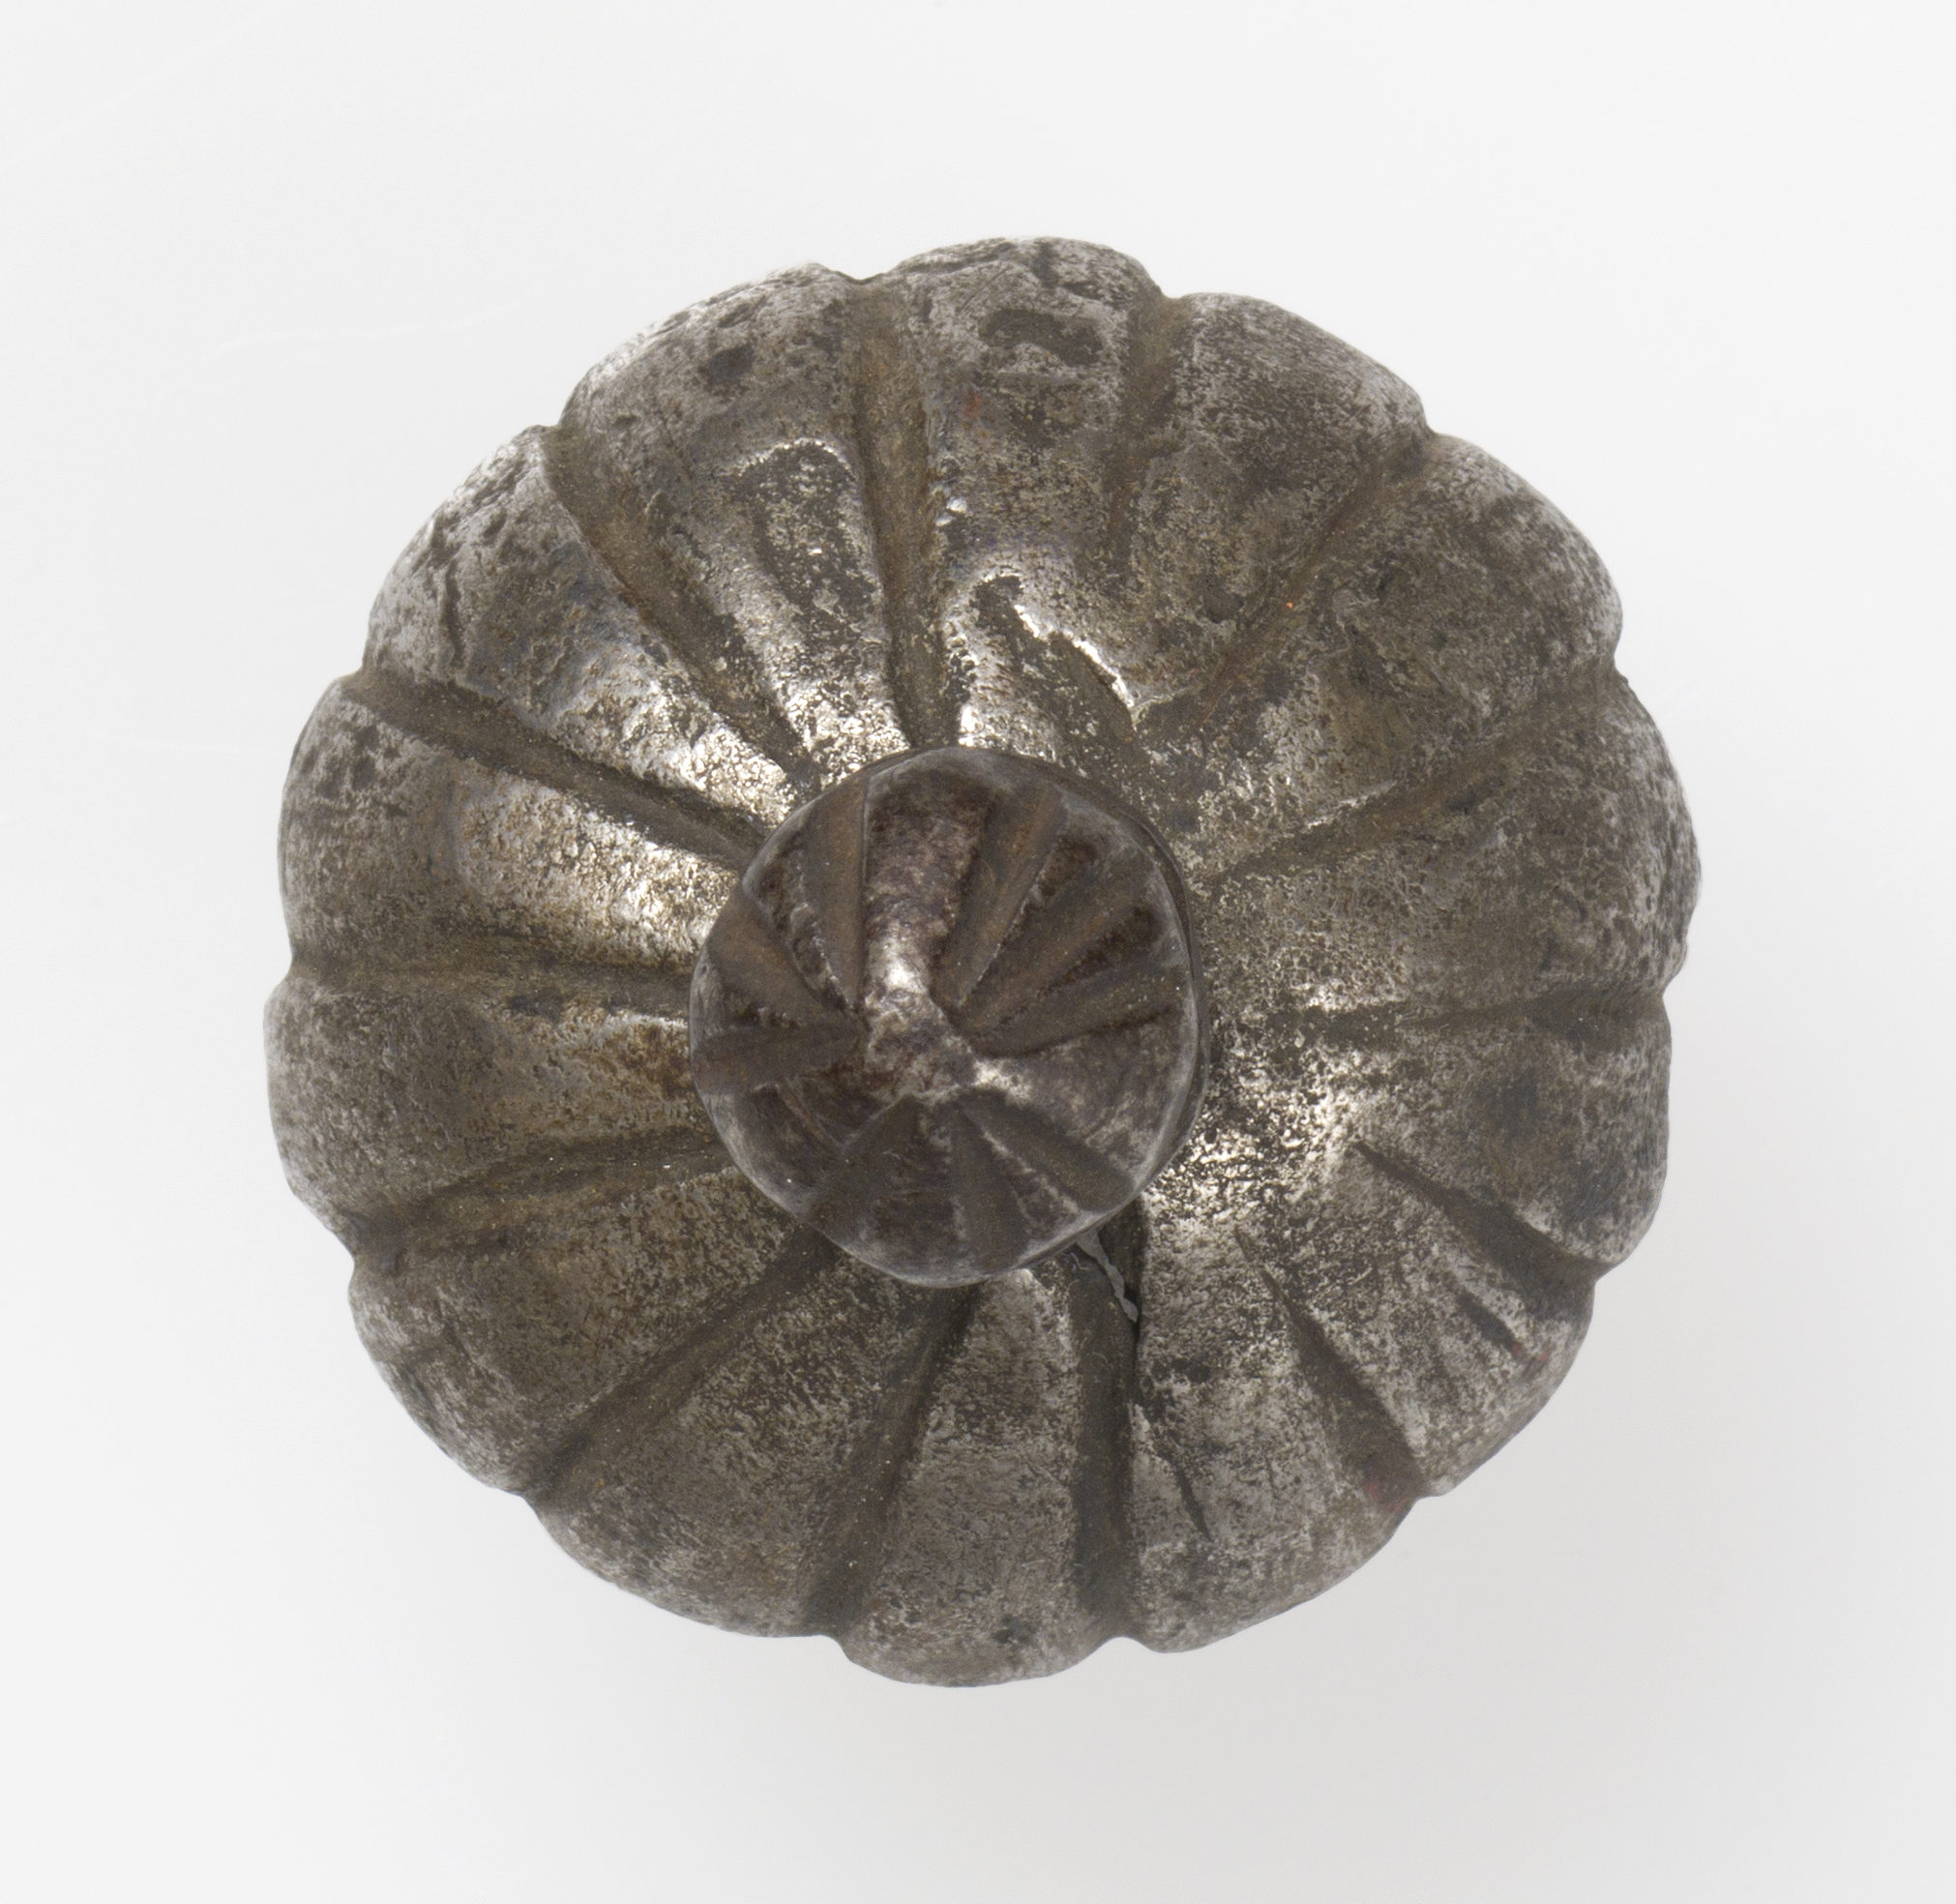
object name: bos and nail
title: Boss and Nail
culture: european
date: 1401-1600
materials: iron